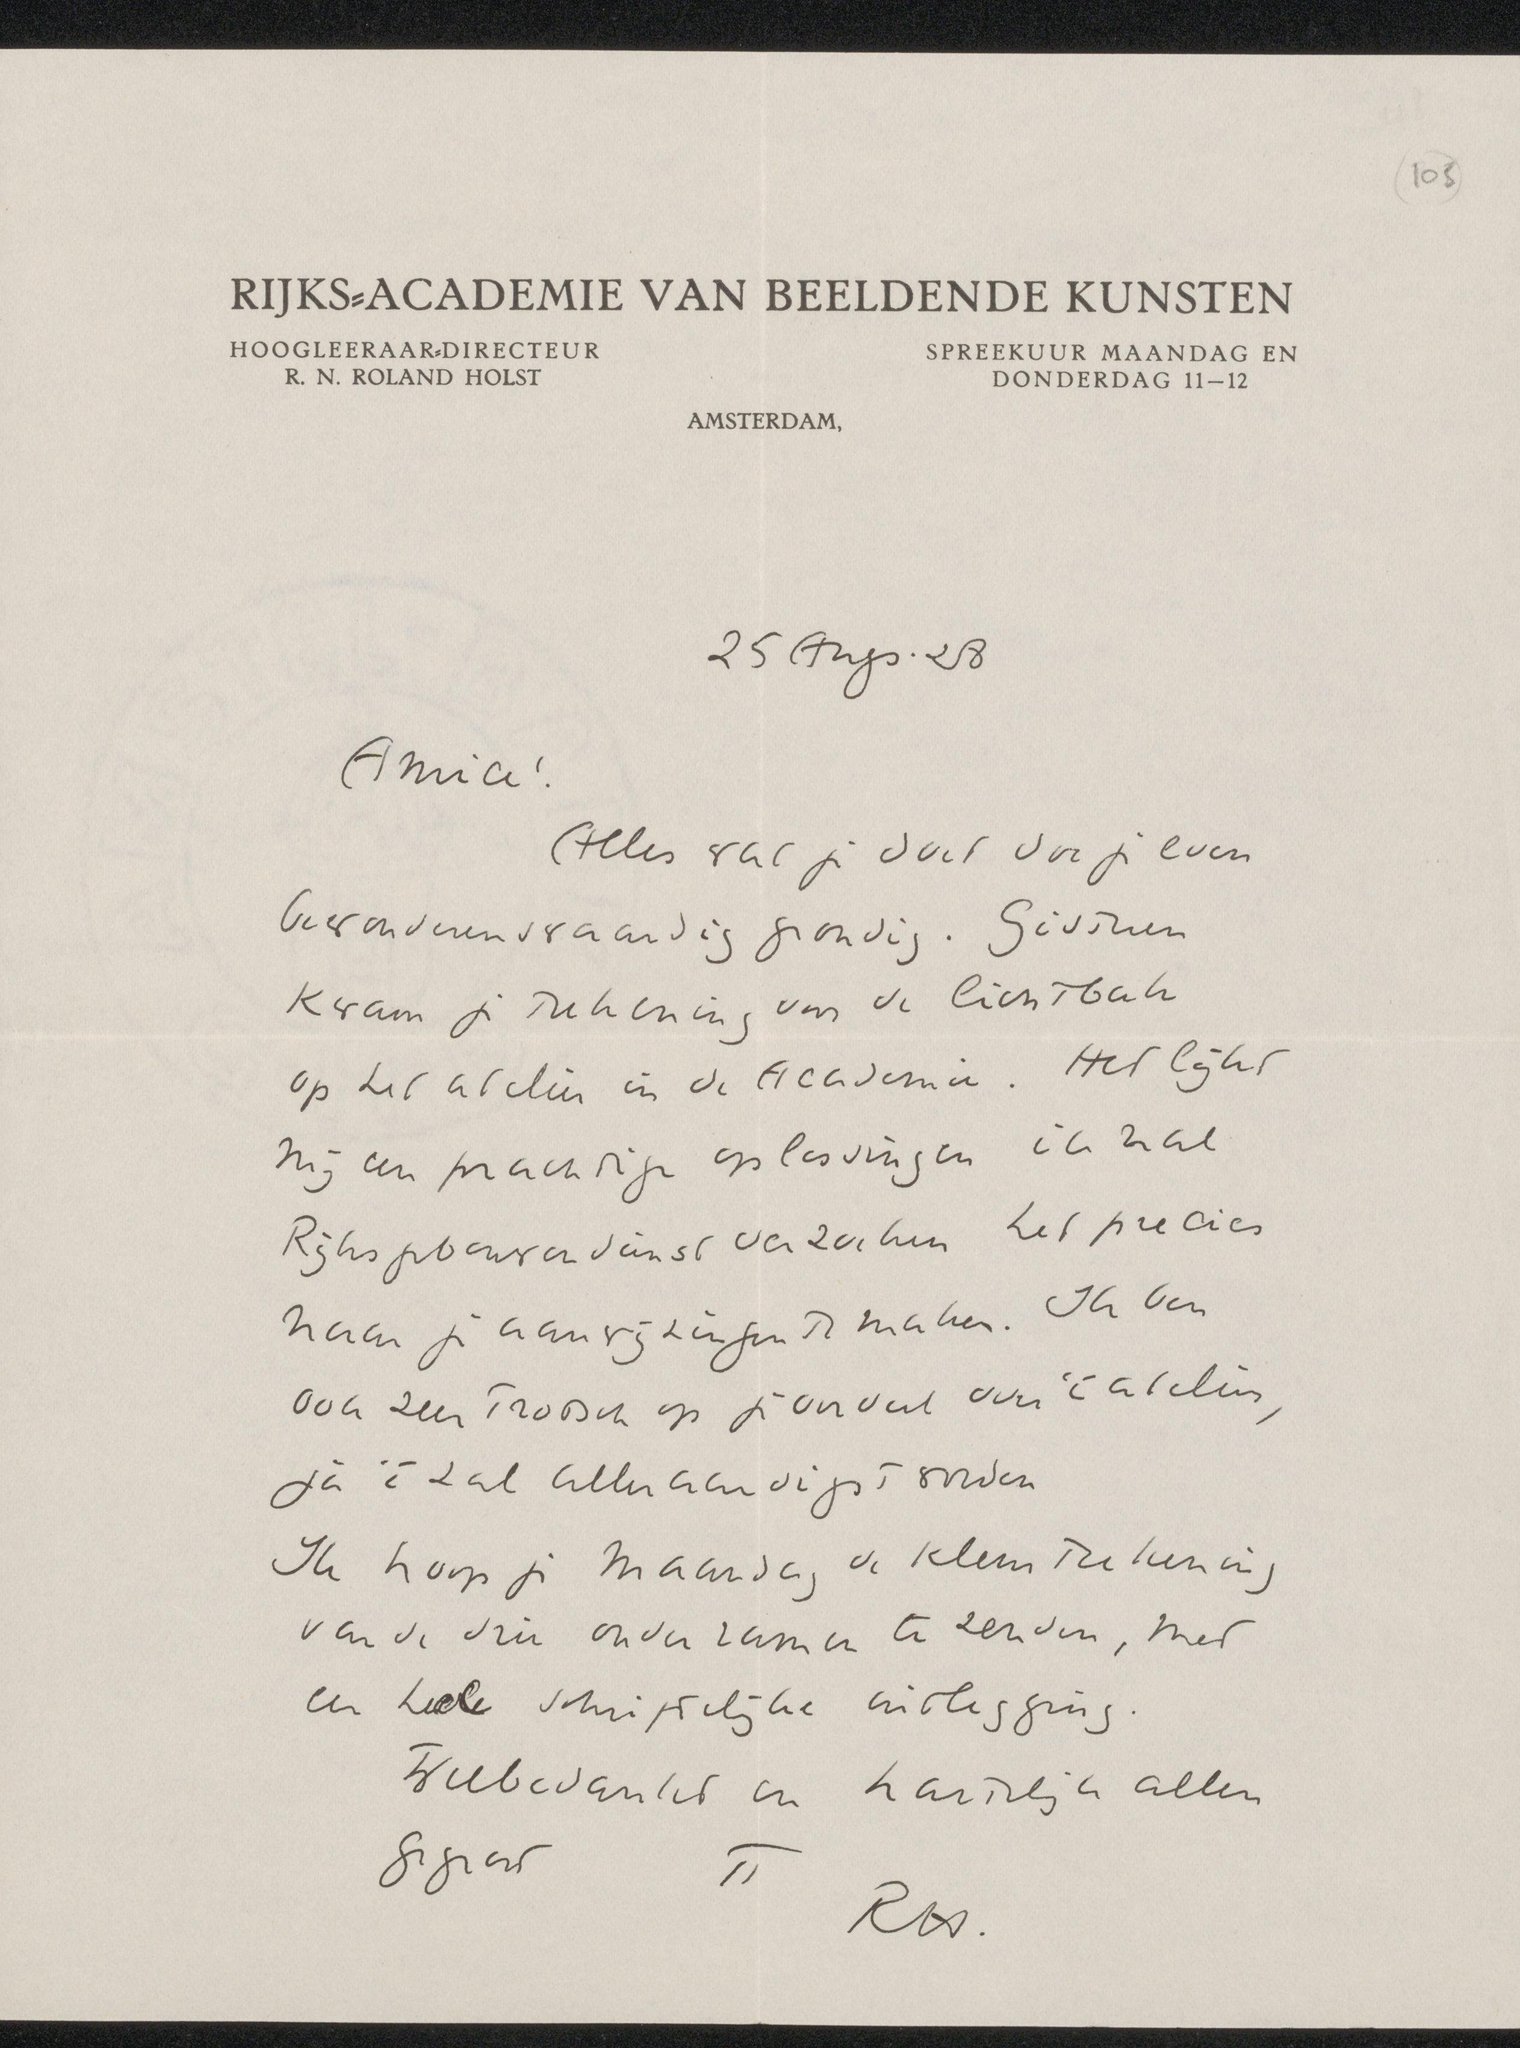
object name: letter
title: Brief aan Willem Bogtman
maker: richard nicolaüs roland holst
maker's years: 1868-1938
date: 1928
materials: ink, paper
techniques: pen, printing, writing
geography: amsterdam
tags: willem bogtman, drawing, applied arts, arts and crafts; industrial design, workshop, studio of the artist (in general)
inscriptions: watermark